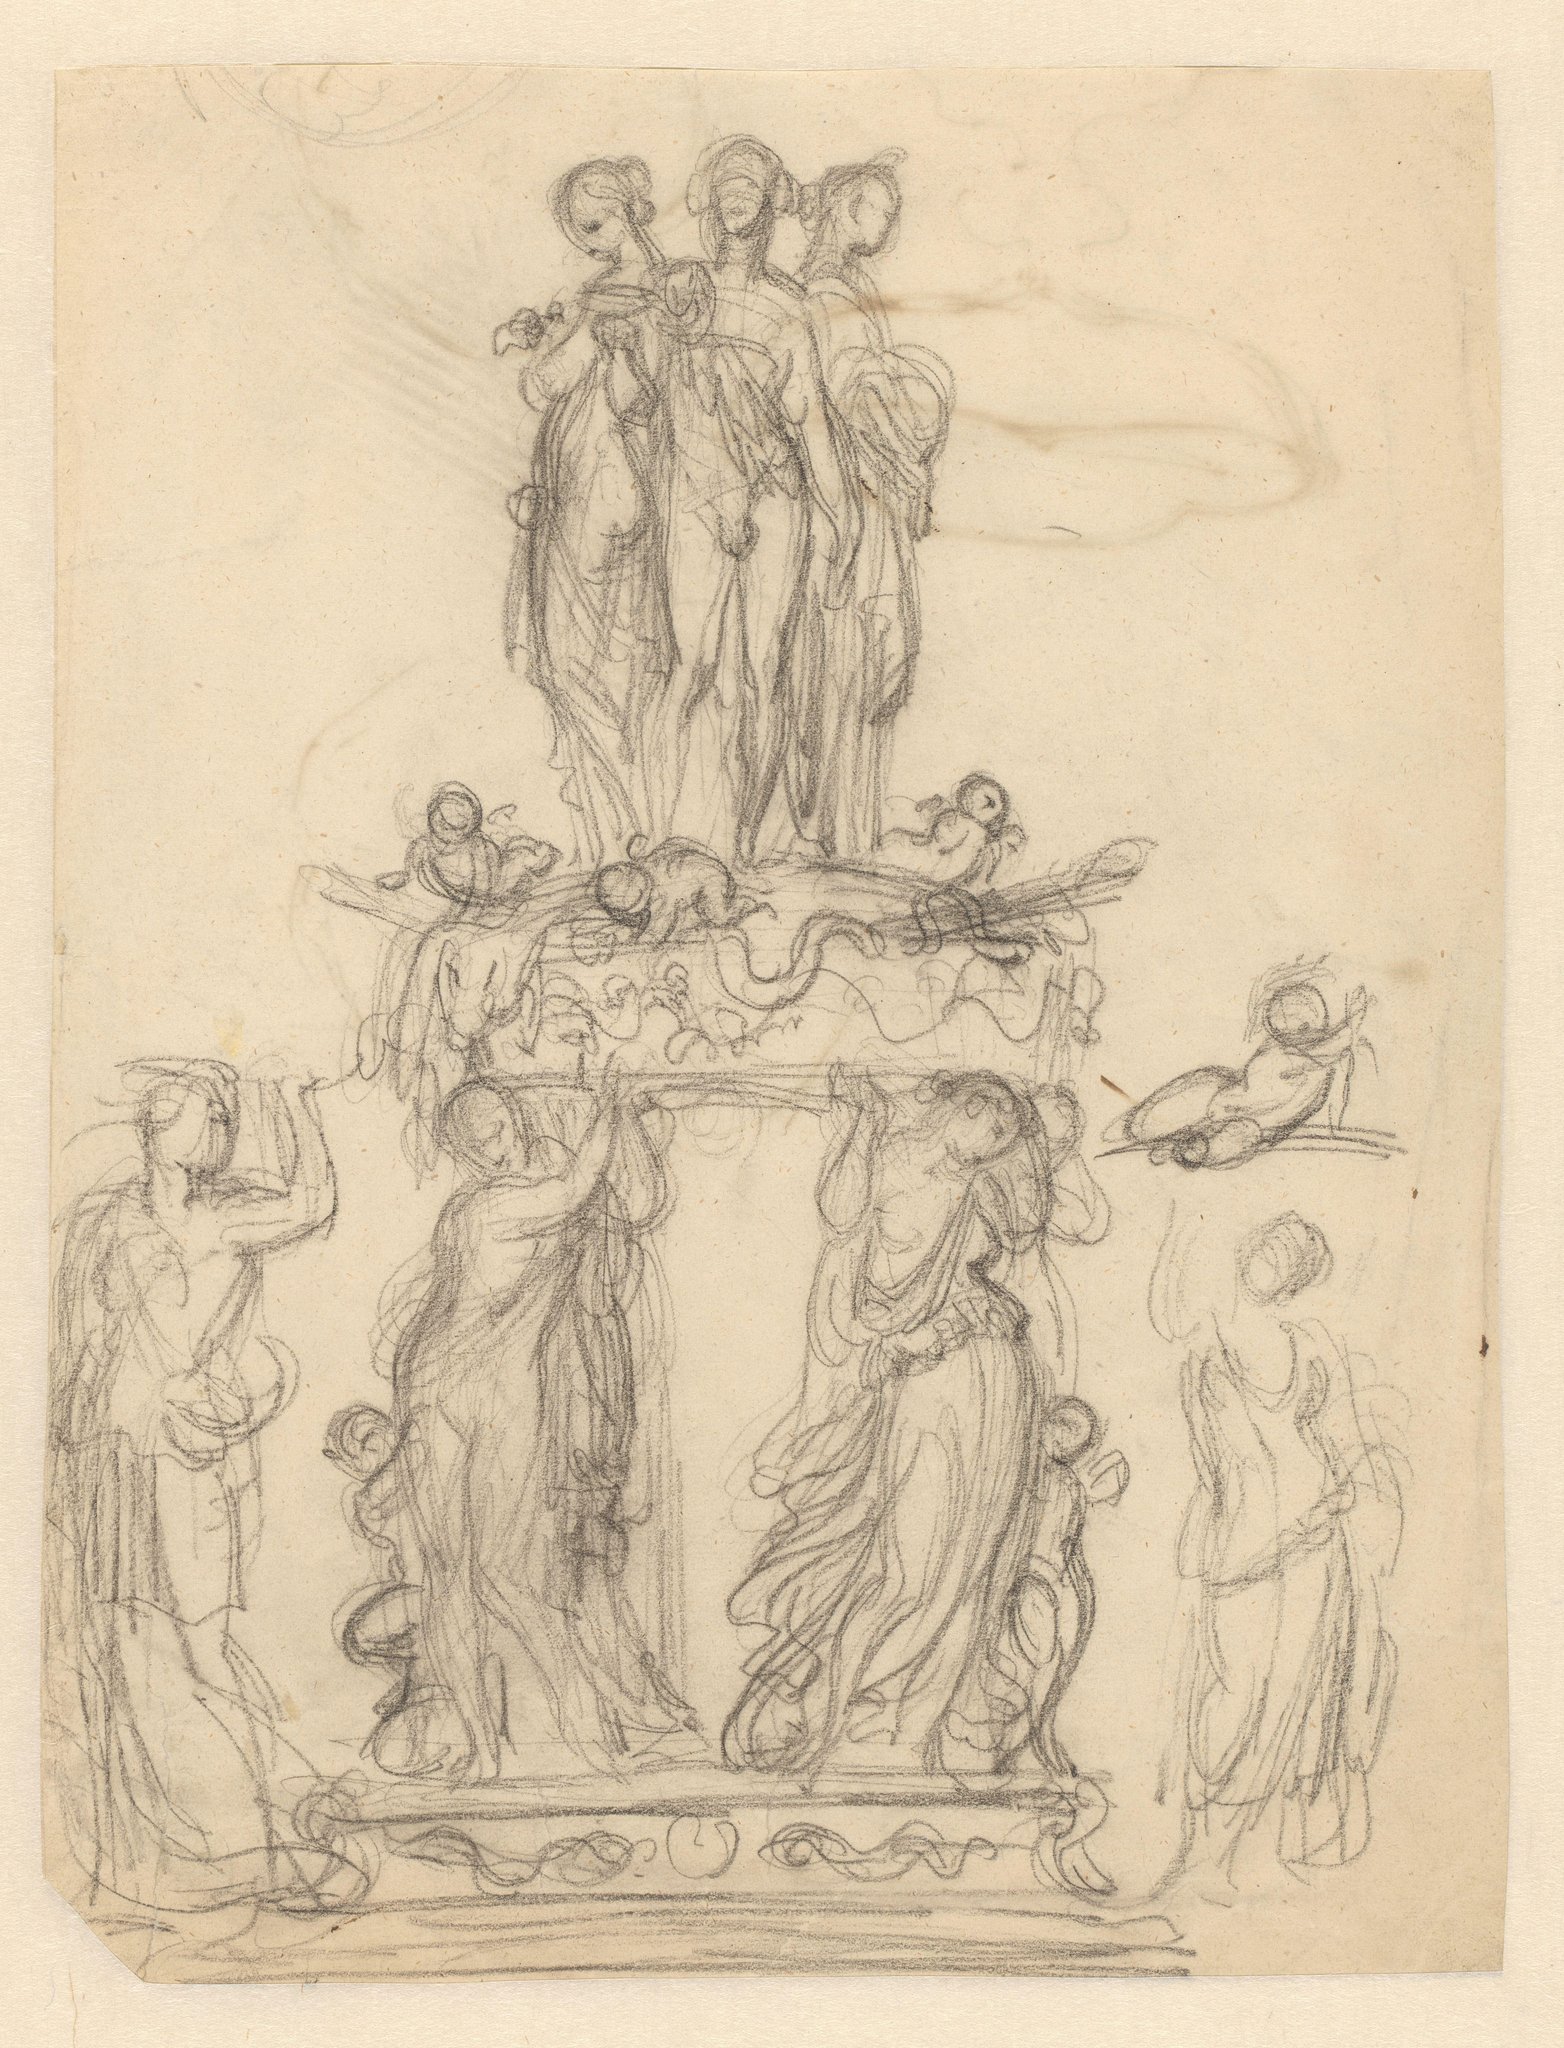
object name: design drawing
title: Schetsen voor een tafelstuk met mannelijke en vrouwelijke figuren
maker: jean-jacques feuchère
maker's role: draughtsman, painter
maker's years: 1807-1852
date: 1835-1845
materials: graphite, paper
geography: paris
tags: centre-piece, epergne, 'surtout', 'milieu-de-table'